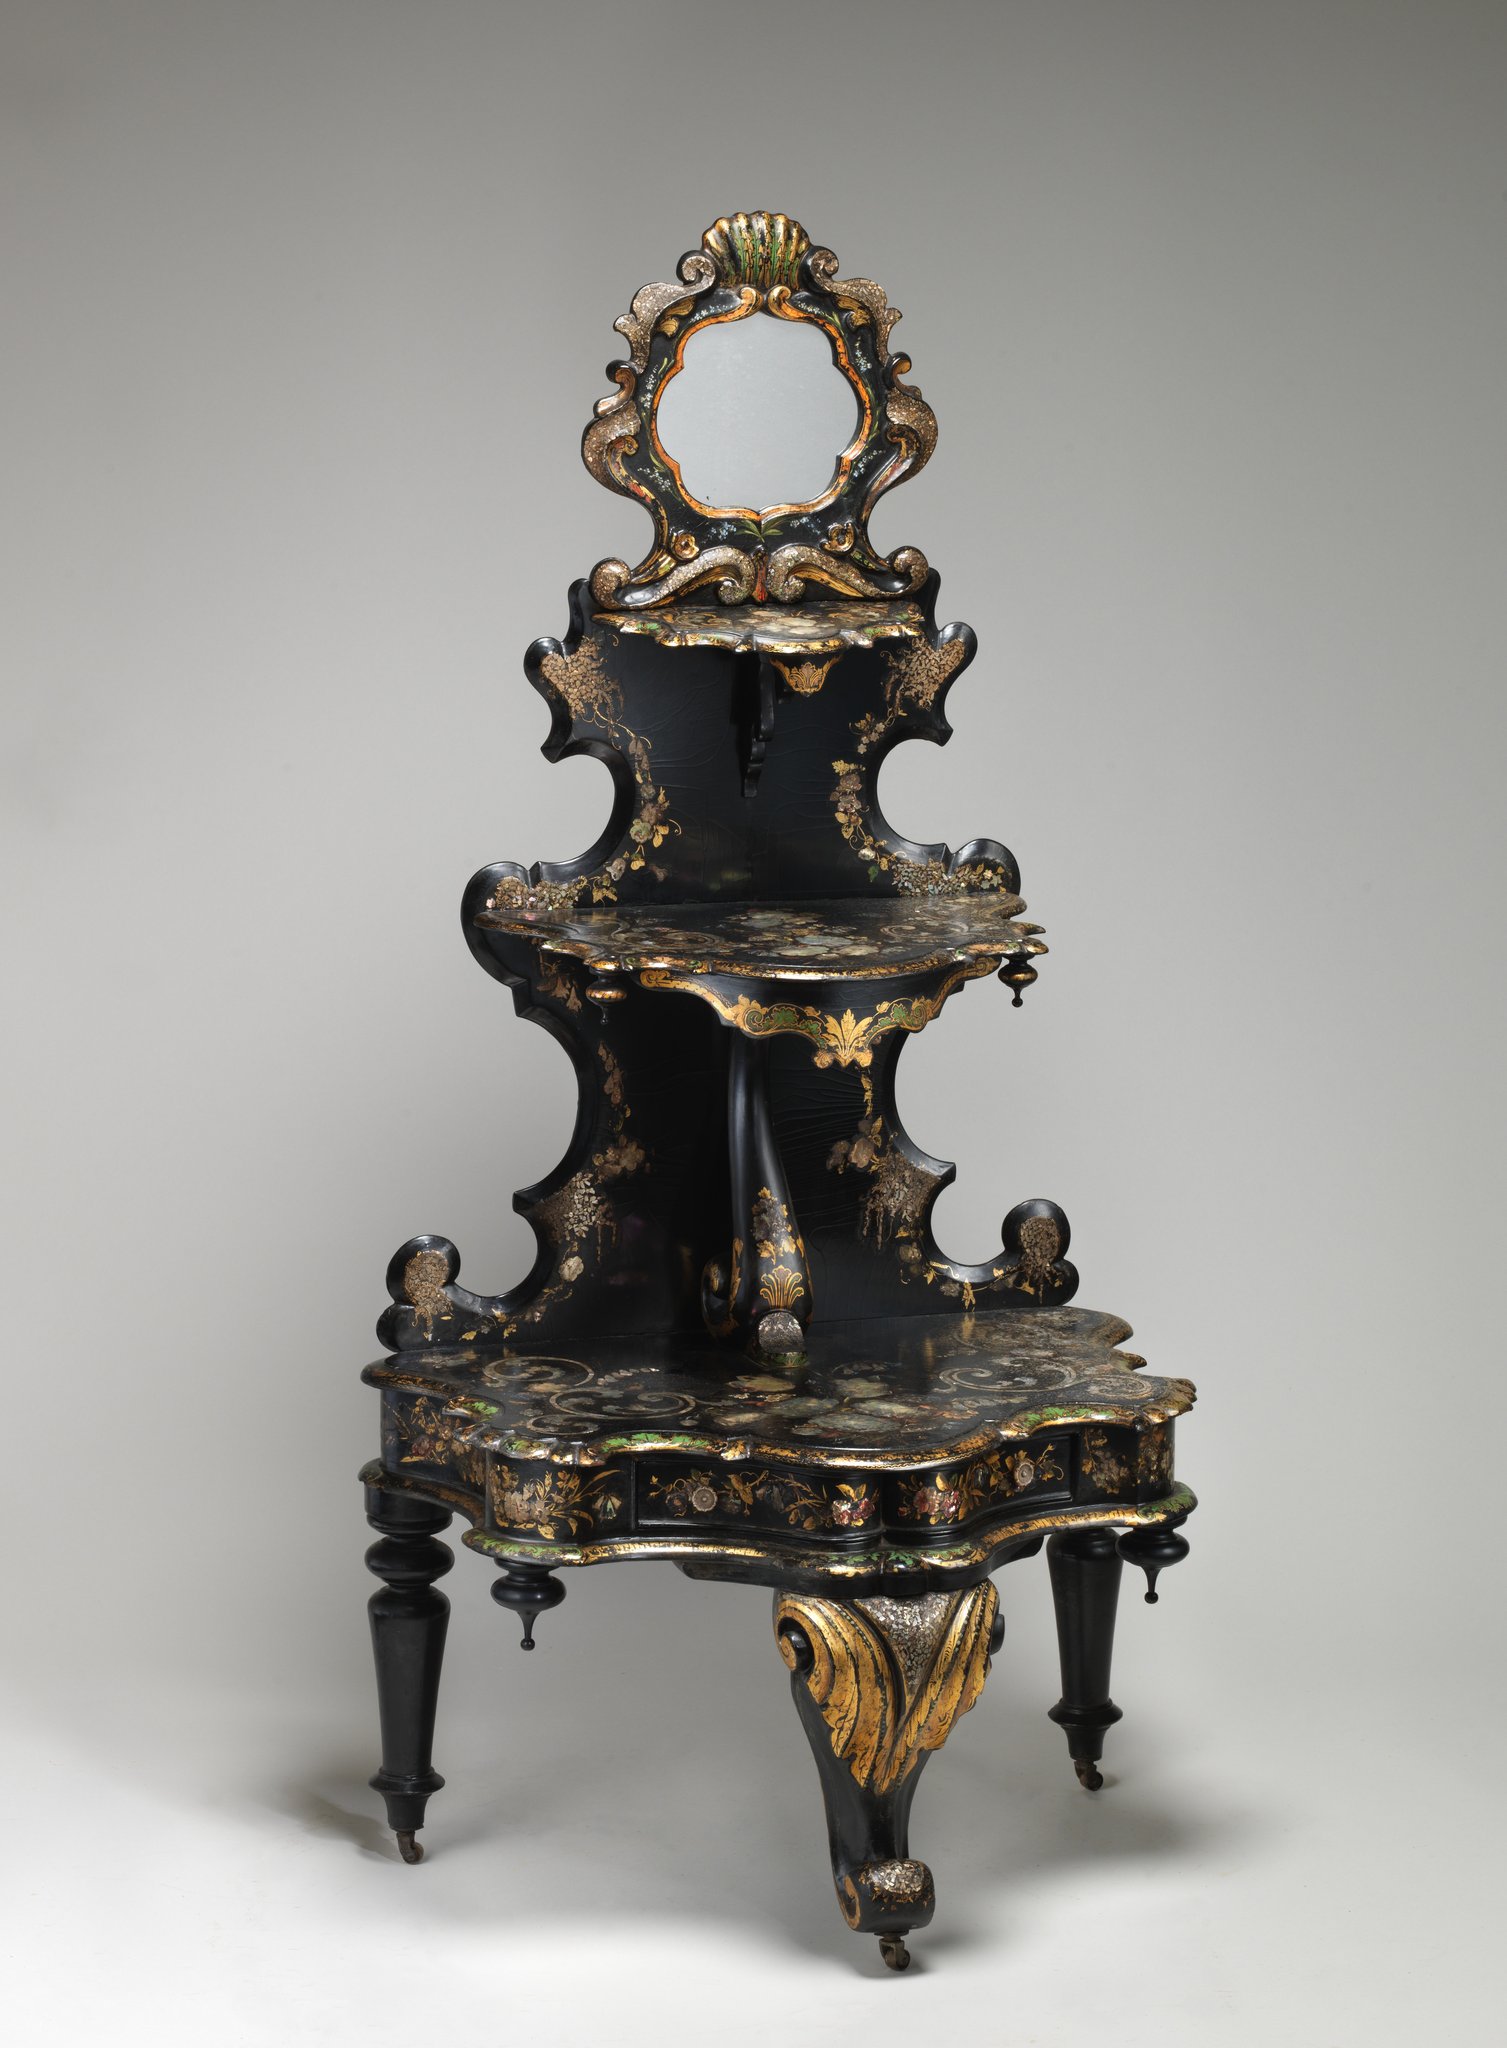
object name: étagère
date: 1834-1866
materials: mother of pearl, paper, wood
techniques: gilding, lacquer, painting